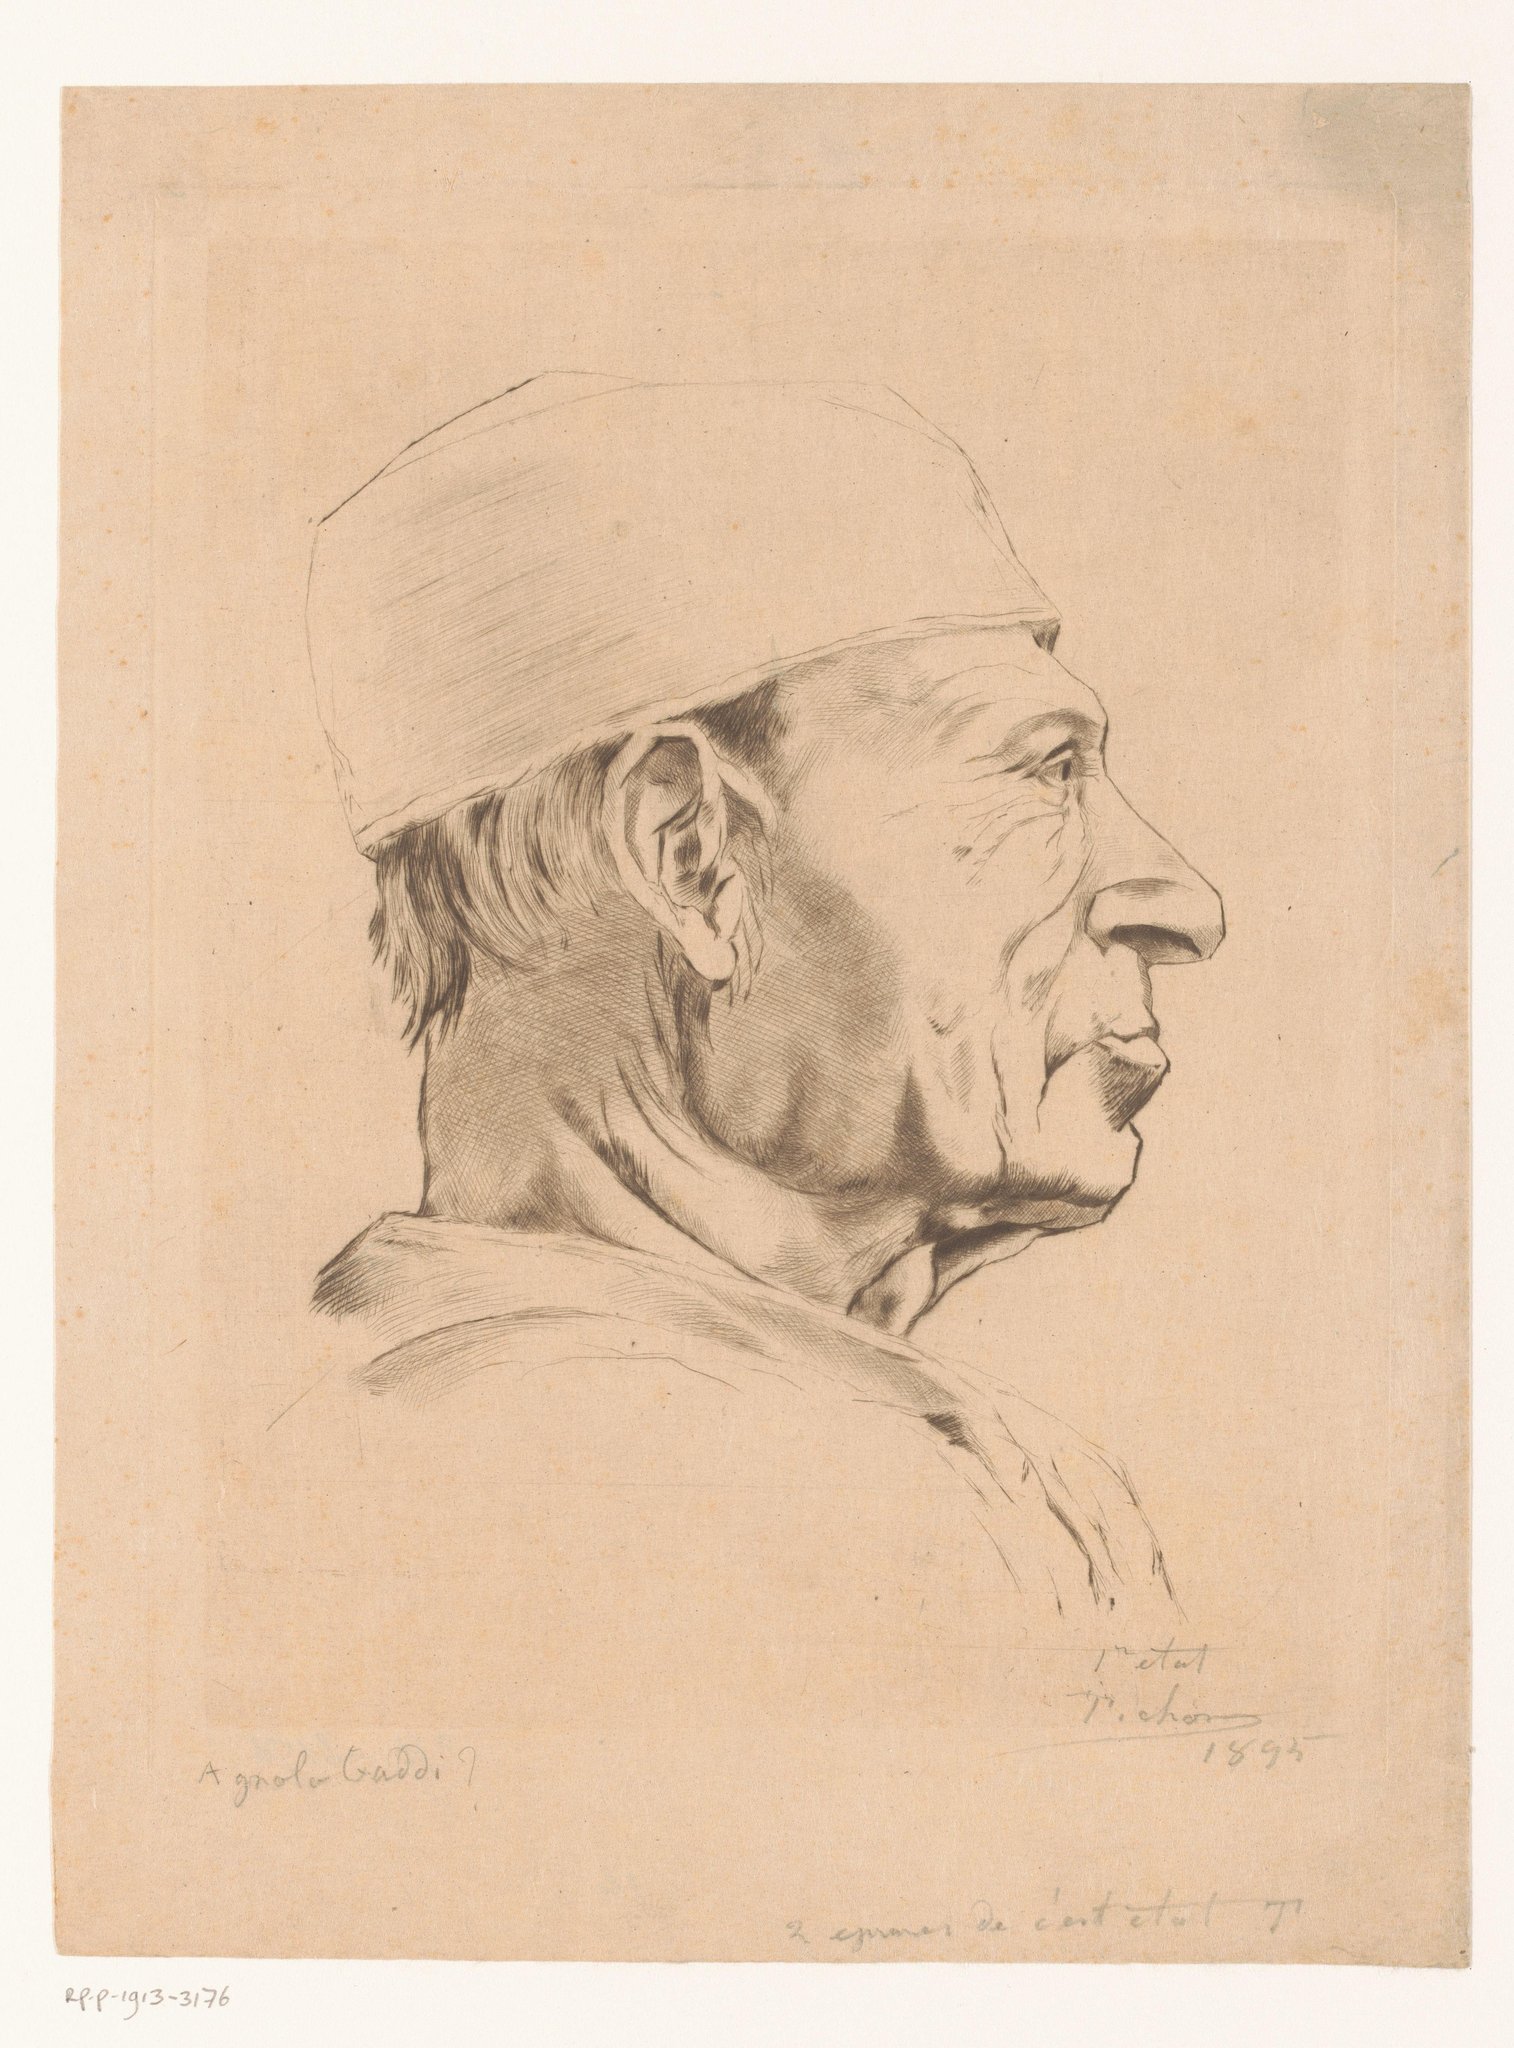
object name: print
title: Portret van een onbekende man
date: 1895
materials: paper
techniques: drypoint, etching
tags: adult man, historical persons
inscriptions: inscription: ‘1e etat; 1895; 2 epreuves de c'est etat T’, collector's mark: Lugt 2228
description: In de inventaris getiteld: Agnolo Gaddi.